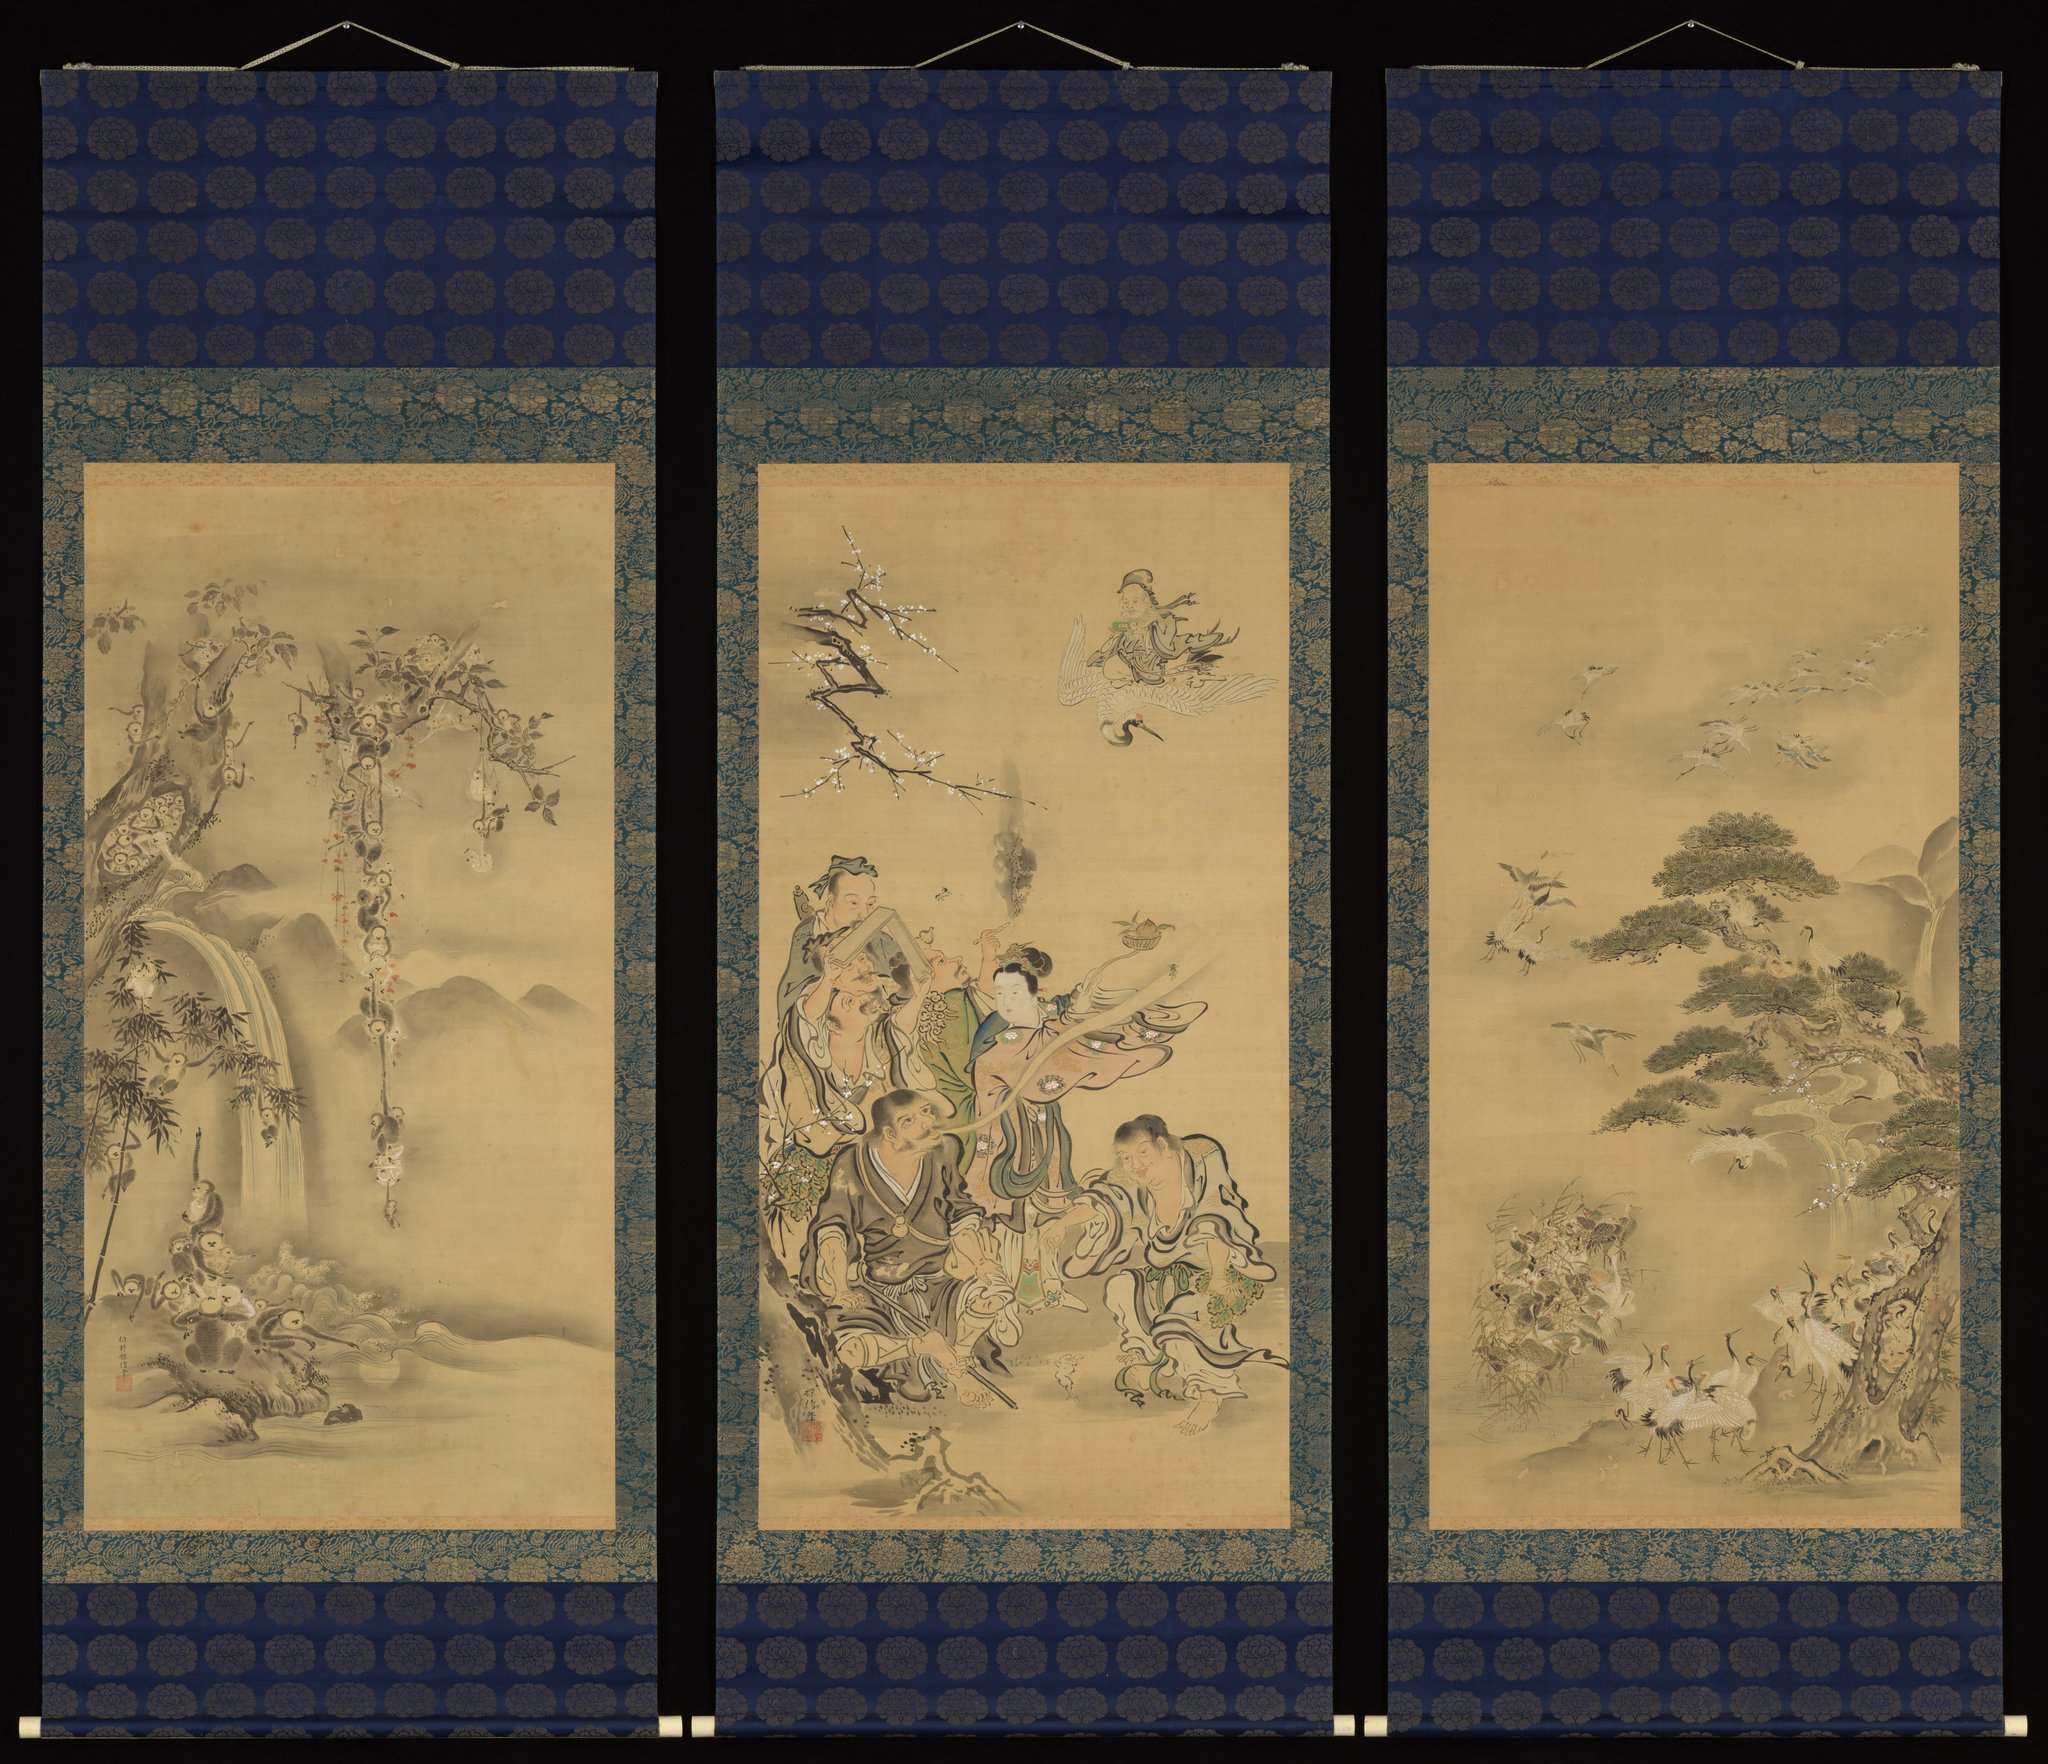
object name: hanging scroll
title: Eight Daoist Immortals, Cranes, and Gibbons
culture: japanese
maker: kano tanshin (morimasa)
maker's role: artist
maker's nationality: japanese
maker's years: 1653-1718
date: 1667-1733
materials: ink, silk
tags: waterfalls,trees